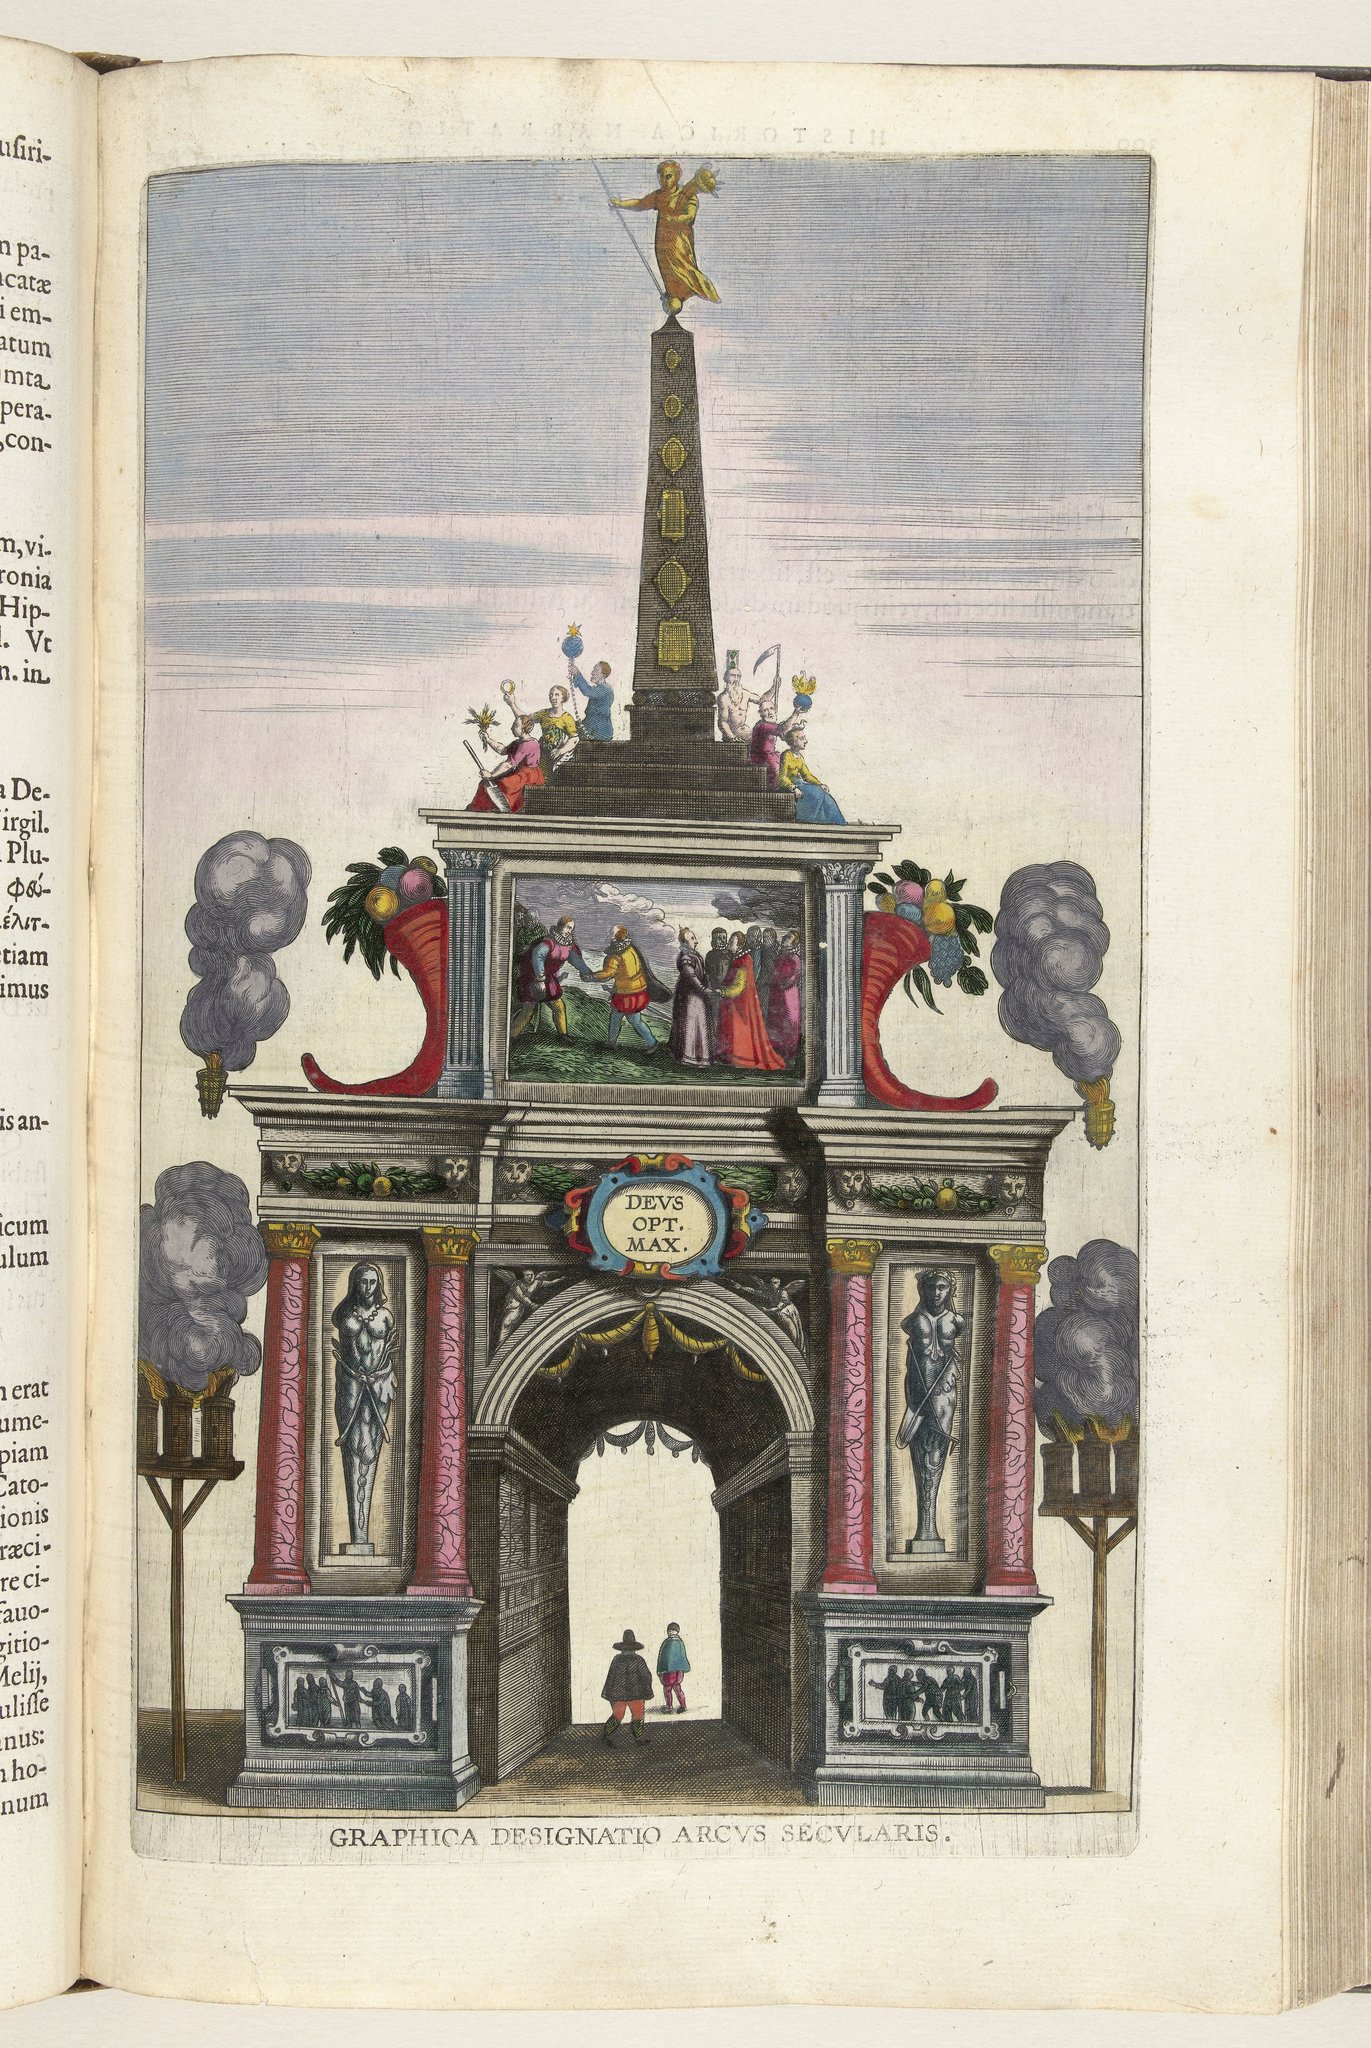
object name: print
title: Graphica designatio arcus secularis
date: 1599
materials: paper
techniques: engraving, hand coloring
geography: antwerp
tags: infante van spanje isabella clara eugenia, brussels, albrecht aartshertog van oostenrijk, triumphal entry and public reception, pageant, 'entrée solennelle', 'joyeuse entrée', antwerp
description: Triomfpoort voor het Eeuwfeest, december 1599. Erepoort versierd met hoornen van overvloed, bovenop een obeslisk en allegorische figuren. Tijdens de intocht te Antwerpen. Onderdeel van: Historica narratio profectionis et inaugurationis serenissimorum Belgii principum Alberti et Isabellae Austriae archiducum, de beschrijving van de intochten van het paar te Brussel, Antwerpen, Gent en Valenciennes, 1599.